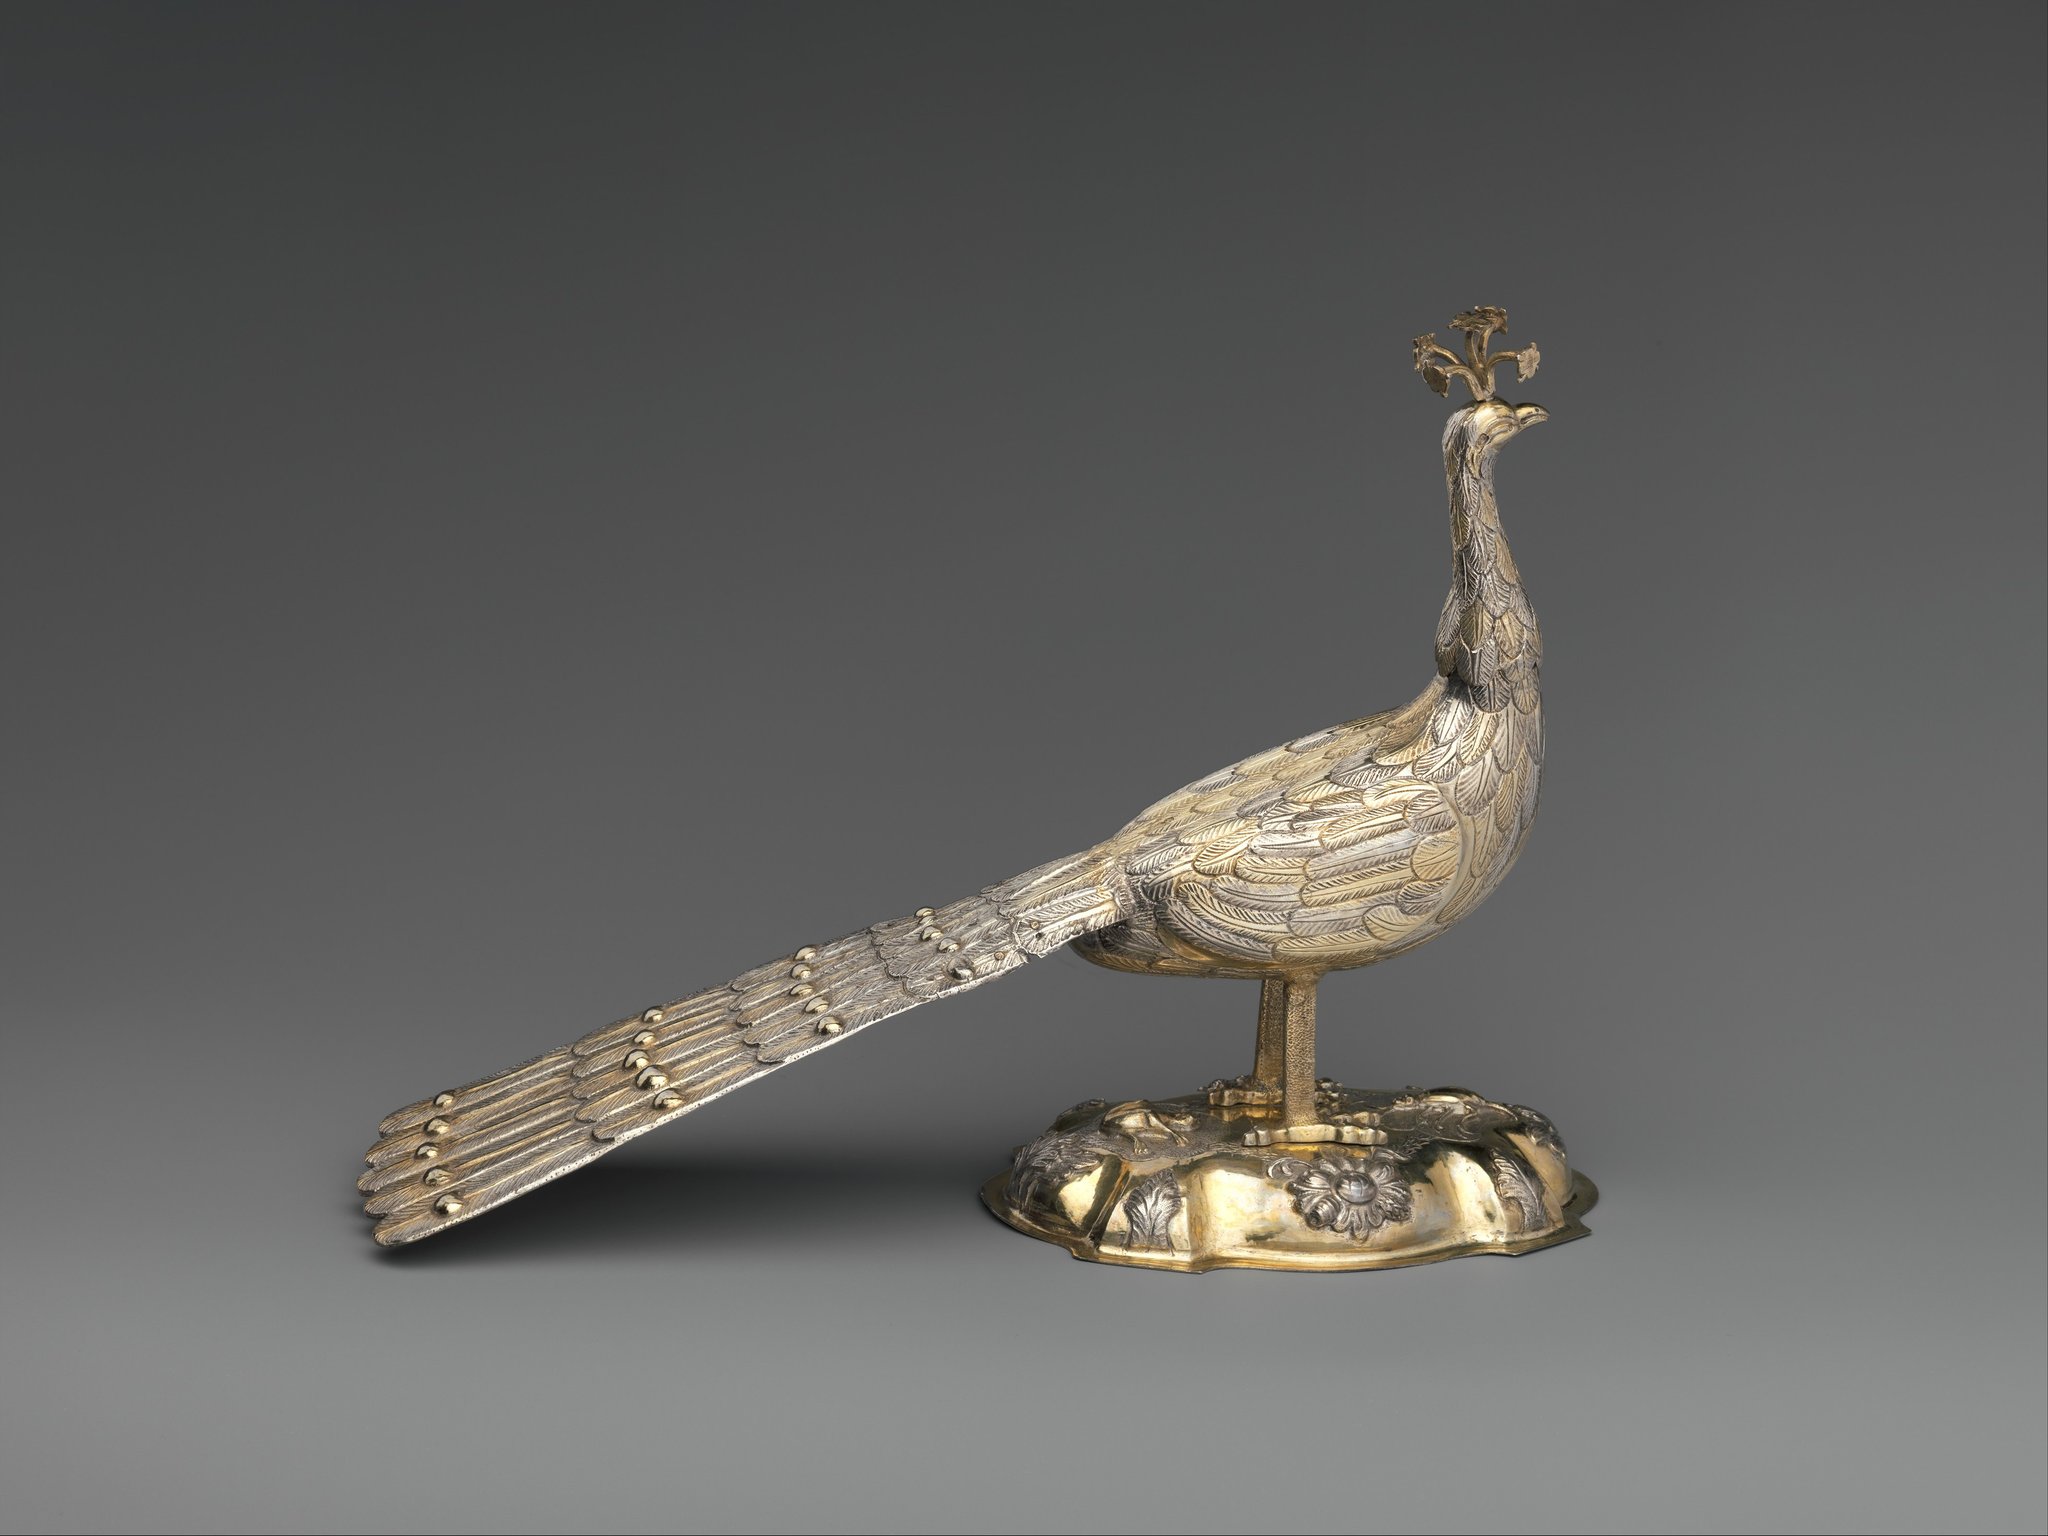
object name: cup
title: Cup in the form of a peacock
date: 1791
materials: silver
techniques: gilding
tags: peacocks